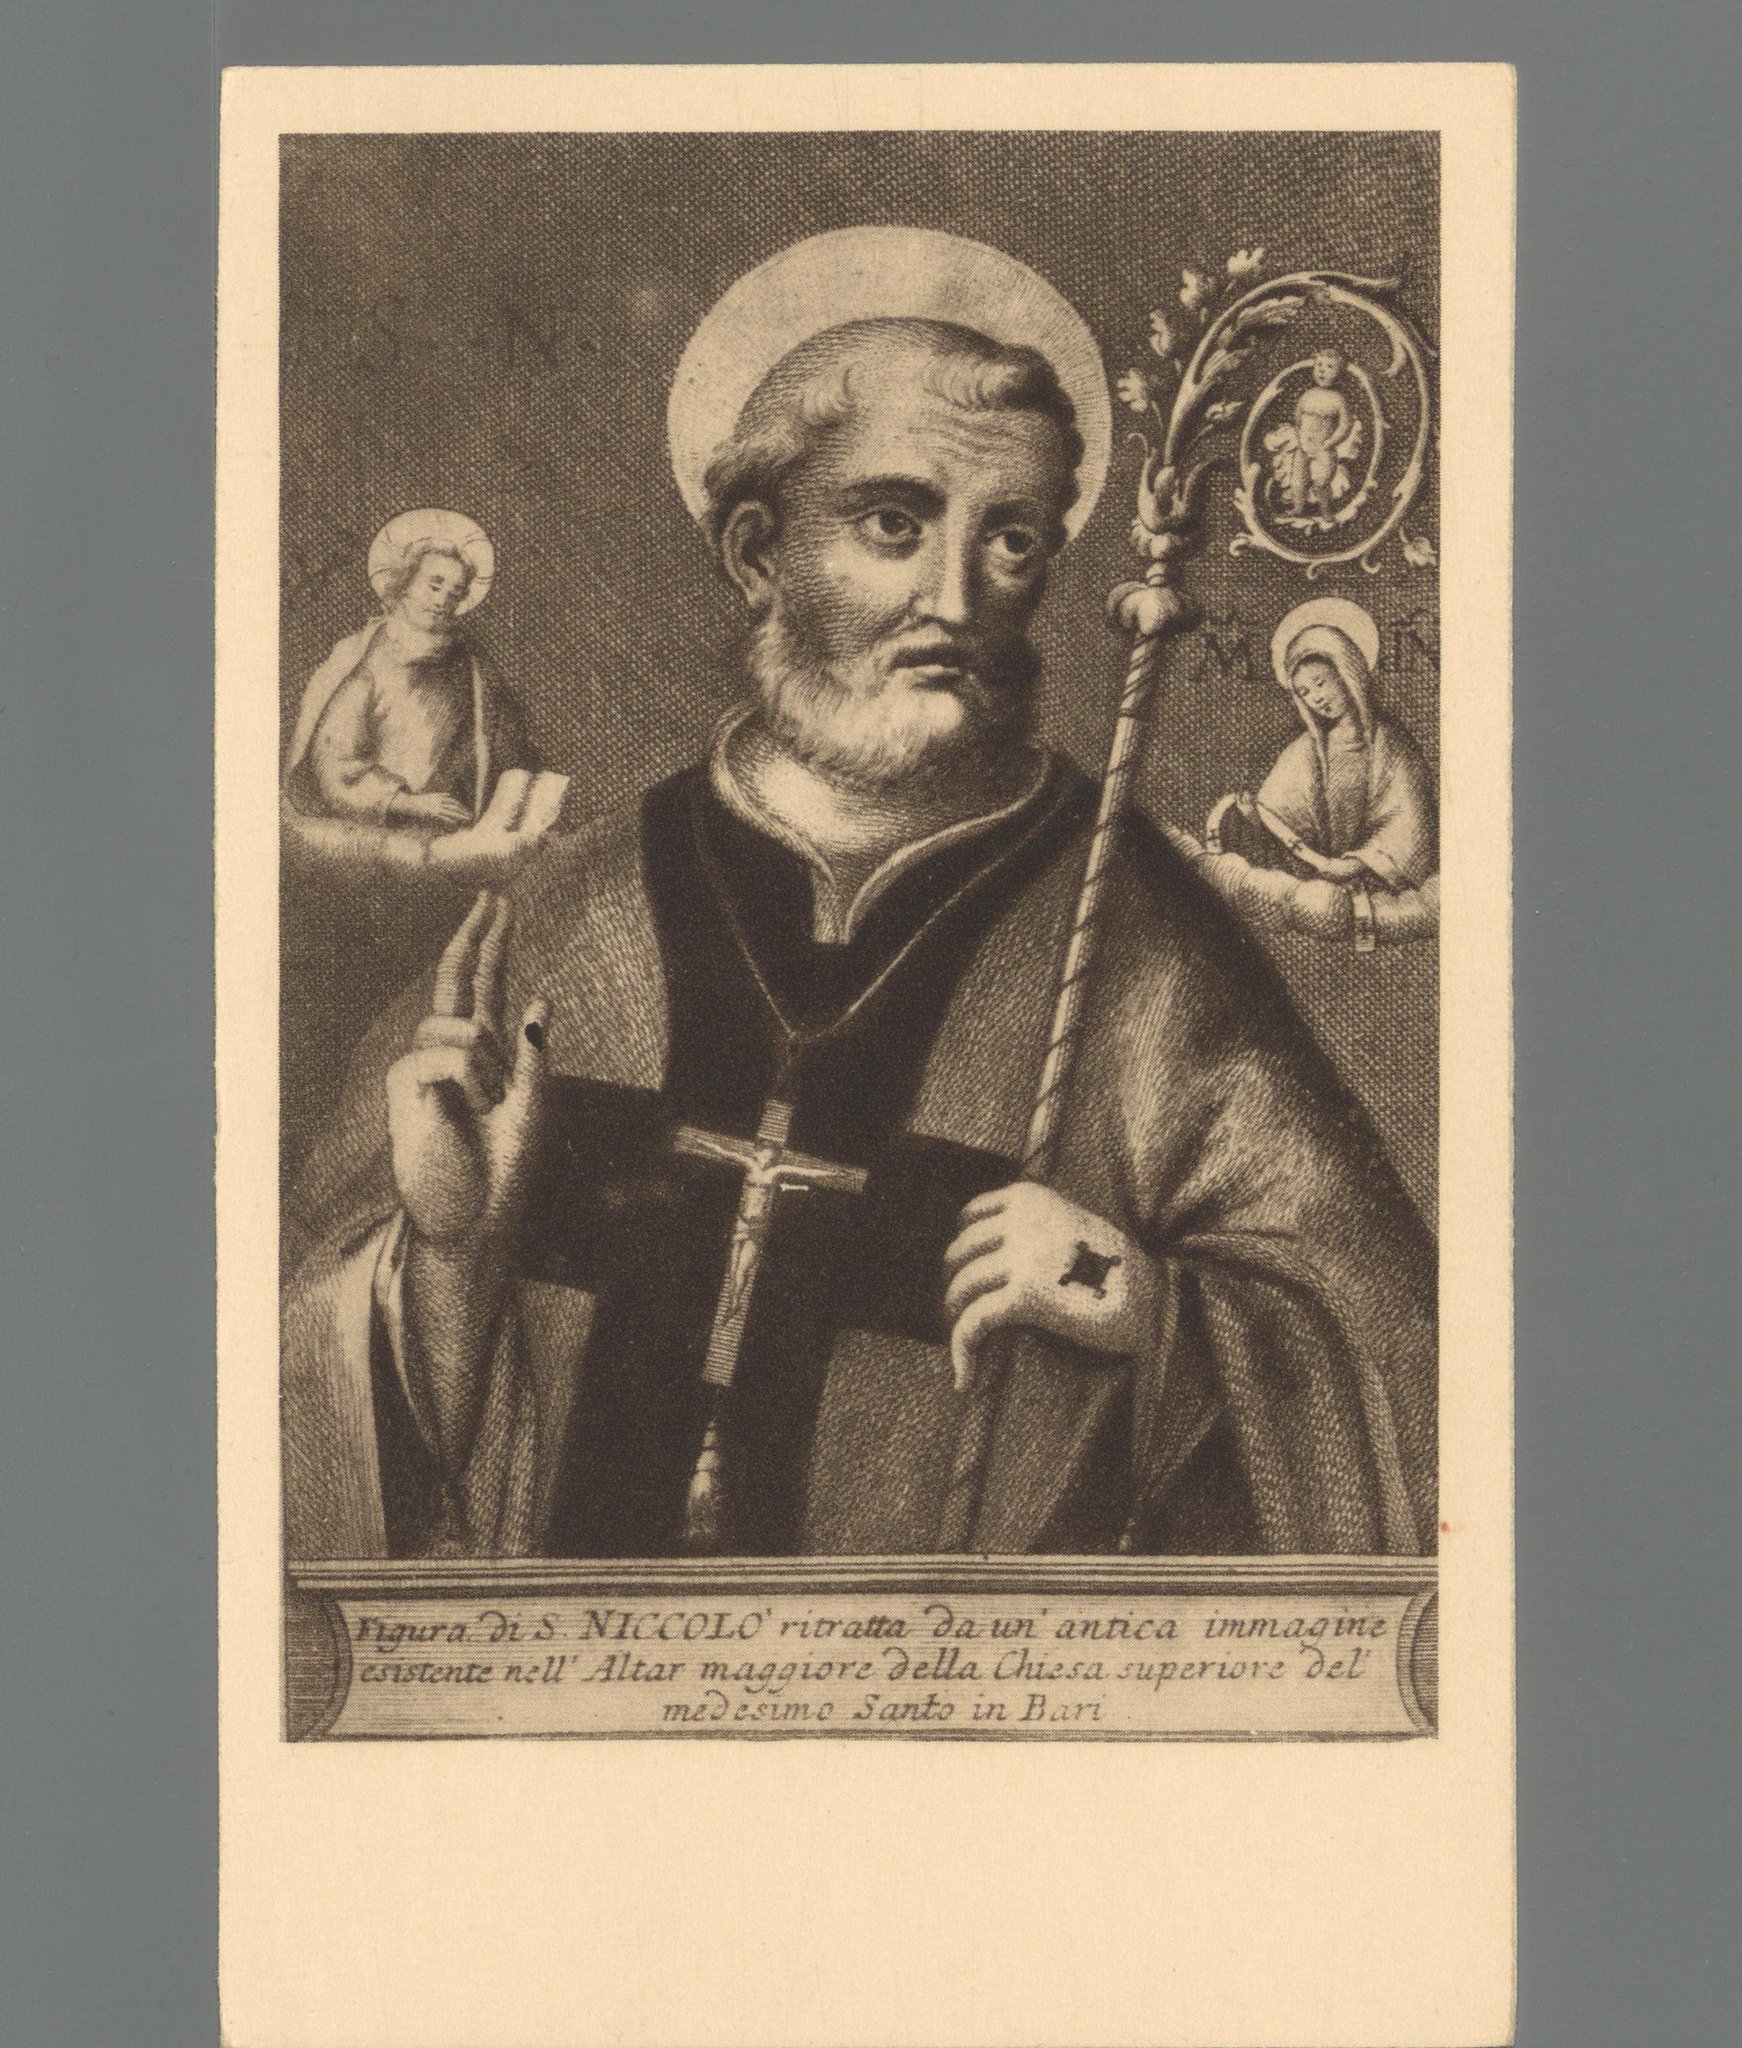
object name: photomechanical print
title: De H. Nicolaas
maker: Anonymous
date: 1928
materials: cardboard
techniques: rotogravure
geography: milan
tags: picture, painting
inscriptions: collector's mark: ‘AFE v S’